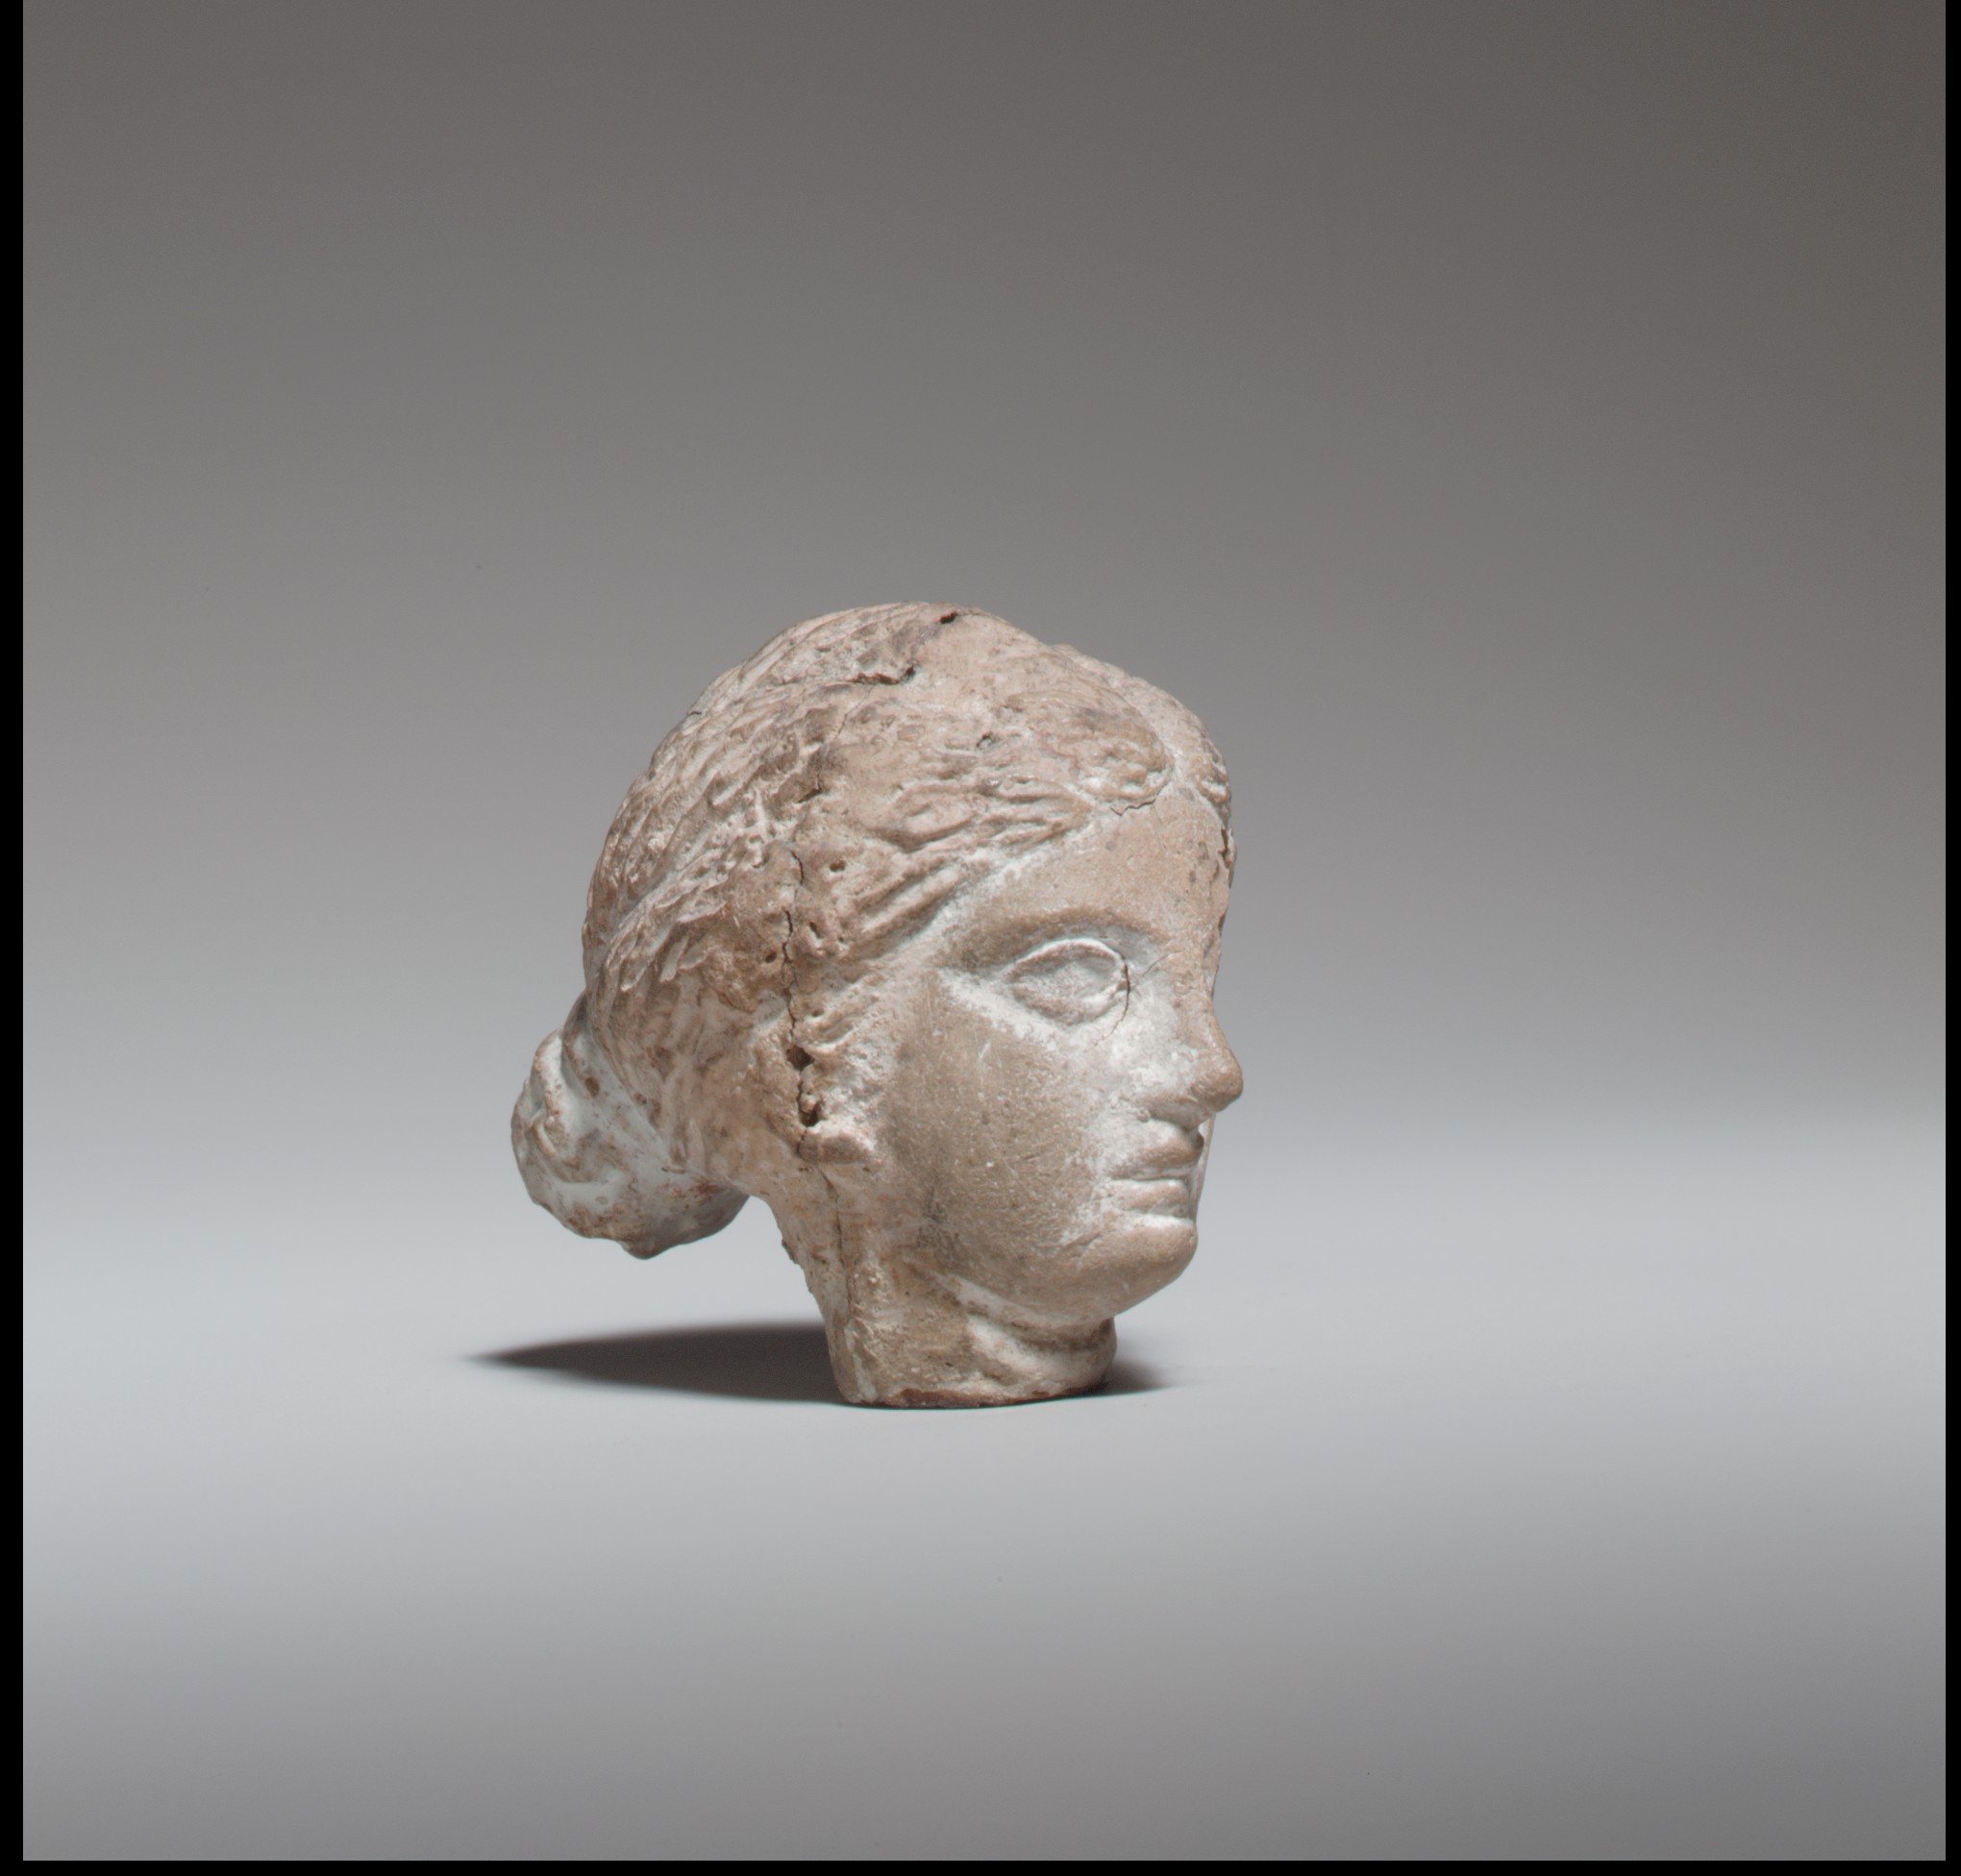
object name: head of a woman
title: Terracotta head of a woman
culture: greek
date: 334-201 BCE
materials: terracotta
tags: heads,women